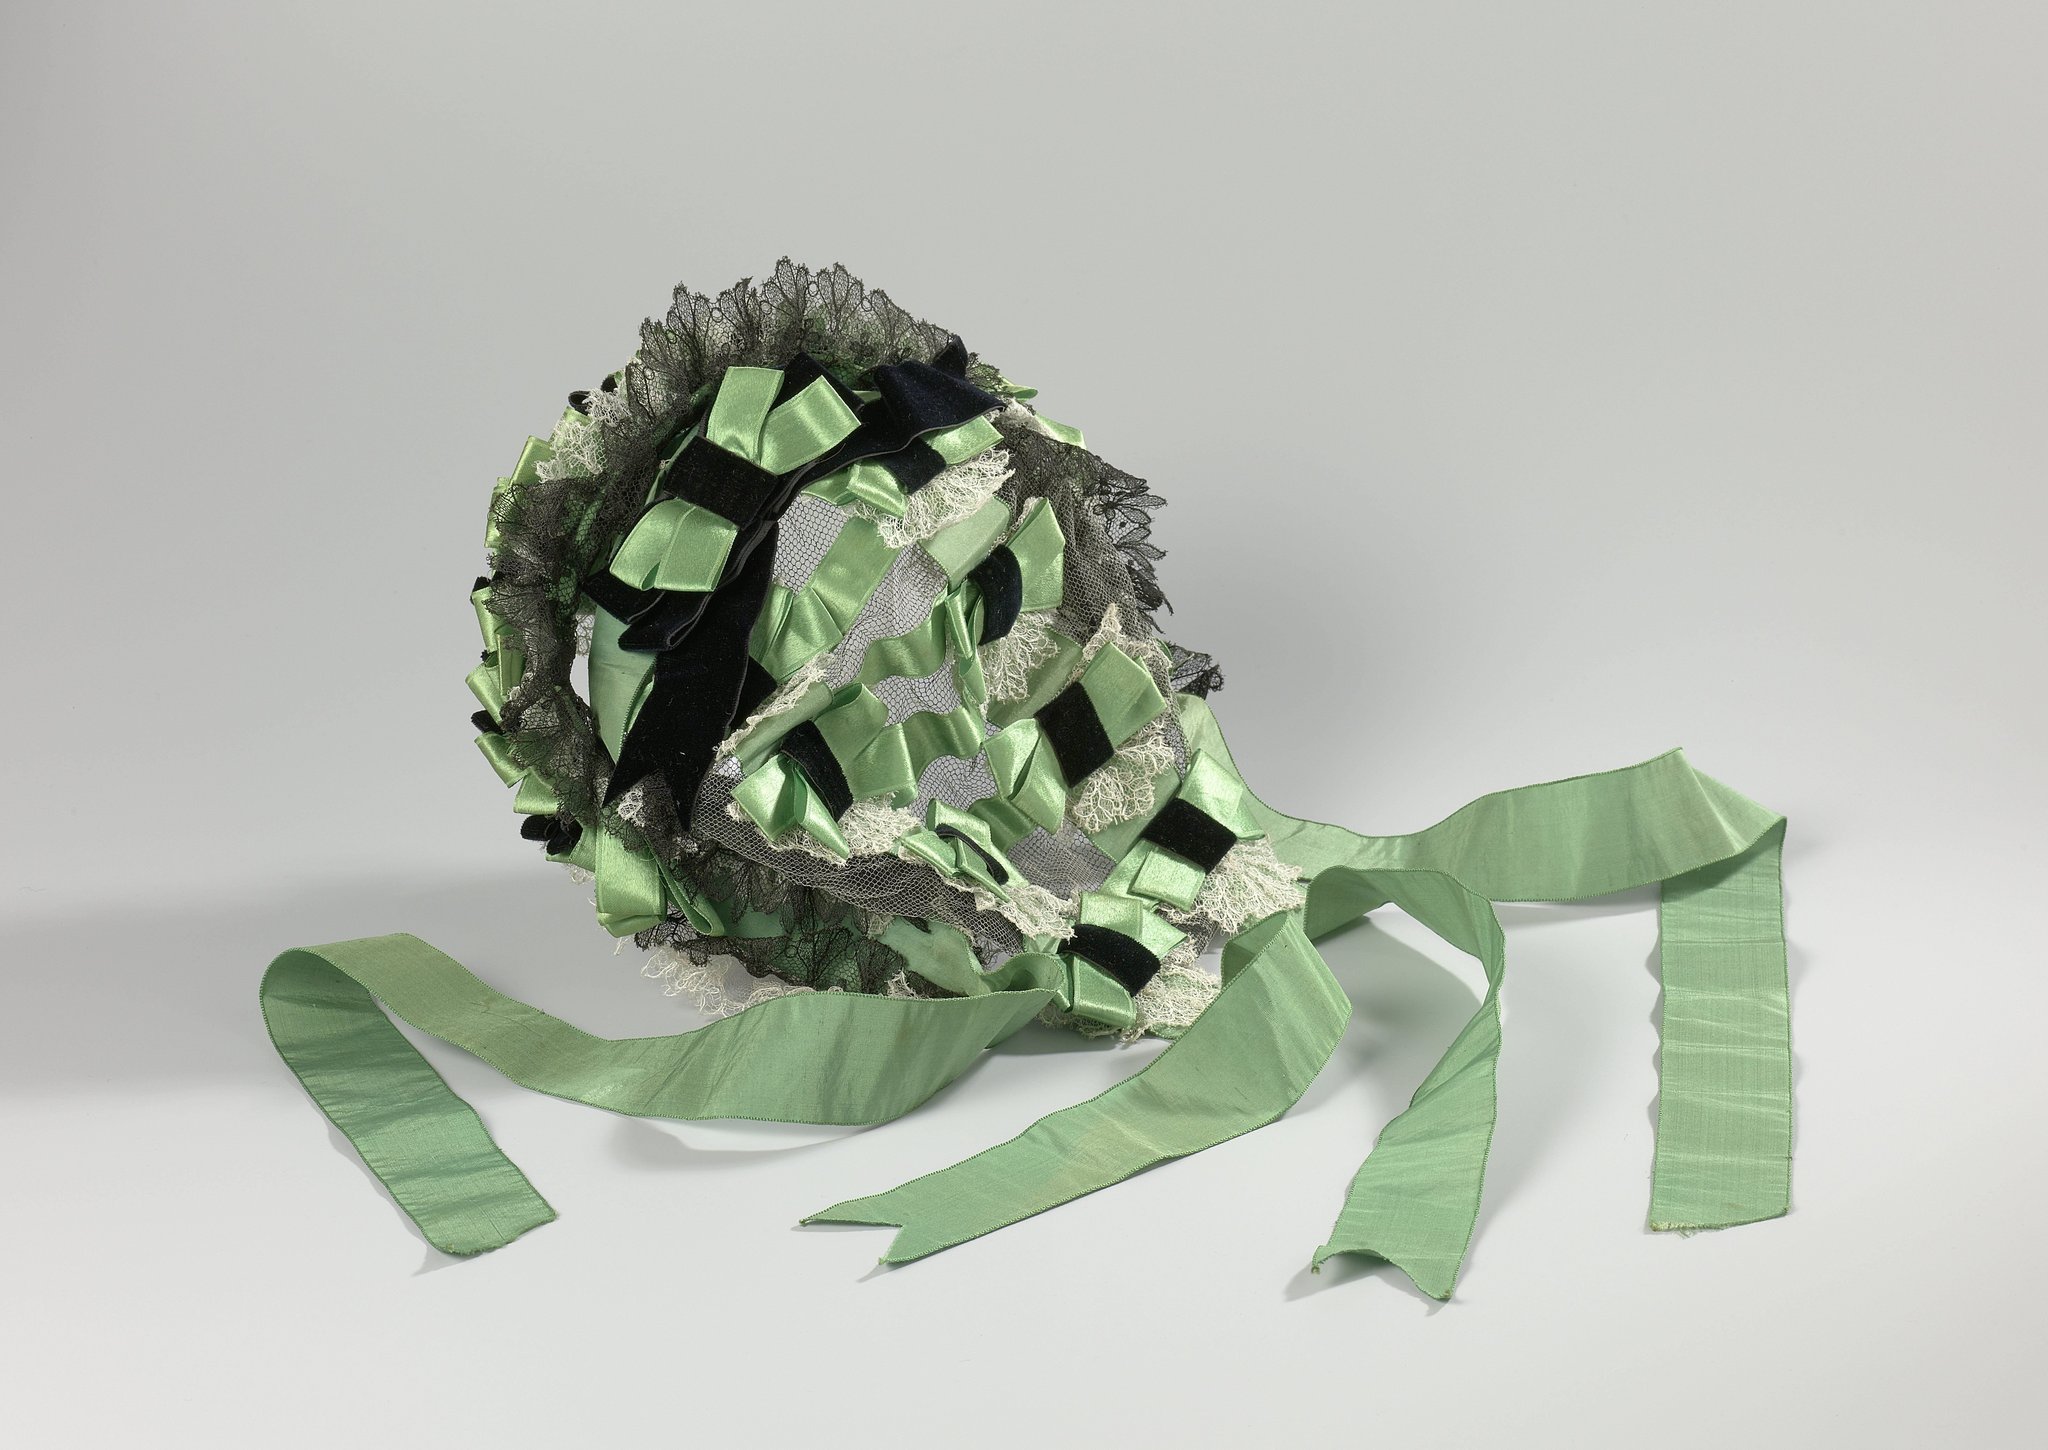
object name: womenswear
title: Bonnet-coiffure van groen satijn, zijden lint, bandfluweel en kant op een zwart tulen ondergrond genaaid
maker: Anonymous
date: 1855-1865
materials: textile, silk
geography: france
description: Bonnet-coiffure, lila en groen, van zijden lint, bandfluweel en kant op een zwarte tullen ondergrond genaaid en met halfronde verstevigde rand van de voorzijde, en met afhangende slippen en linten, achterste deel van bol met elastiekje ingehaald. De gladde rand is geheel bezet met strikken en lussen groen satijnen lint en zwart bandfluweel, en afgezet met stroken witte en zwarte machinale kant. De bol is van witte tulle, is van achter met elastiekje ingenomen, en is gegarneerd met midden bovenaan: zwarte en groene strik, waaruit vier groen zijden linten hangen, de middelste twee op de bol gehecht en versierd met groene strikken met zwarte overslag en kanten strookje, de buitenste onversierd, kunnen onder de kin gestrikt worden.